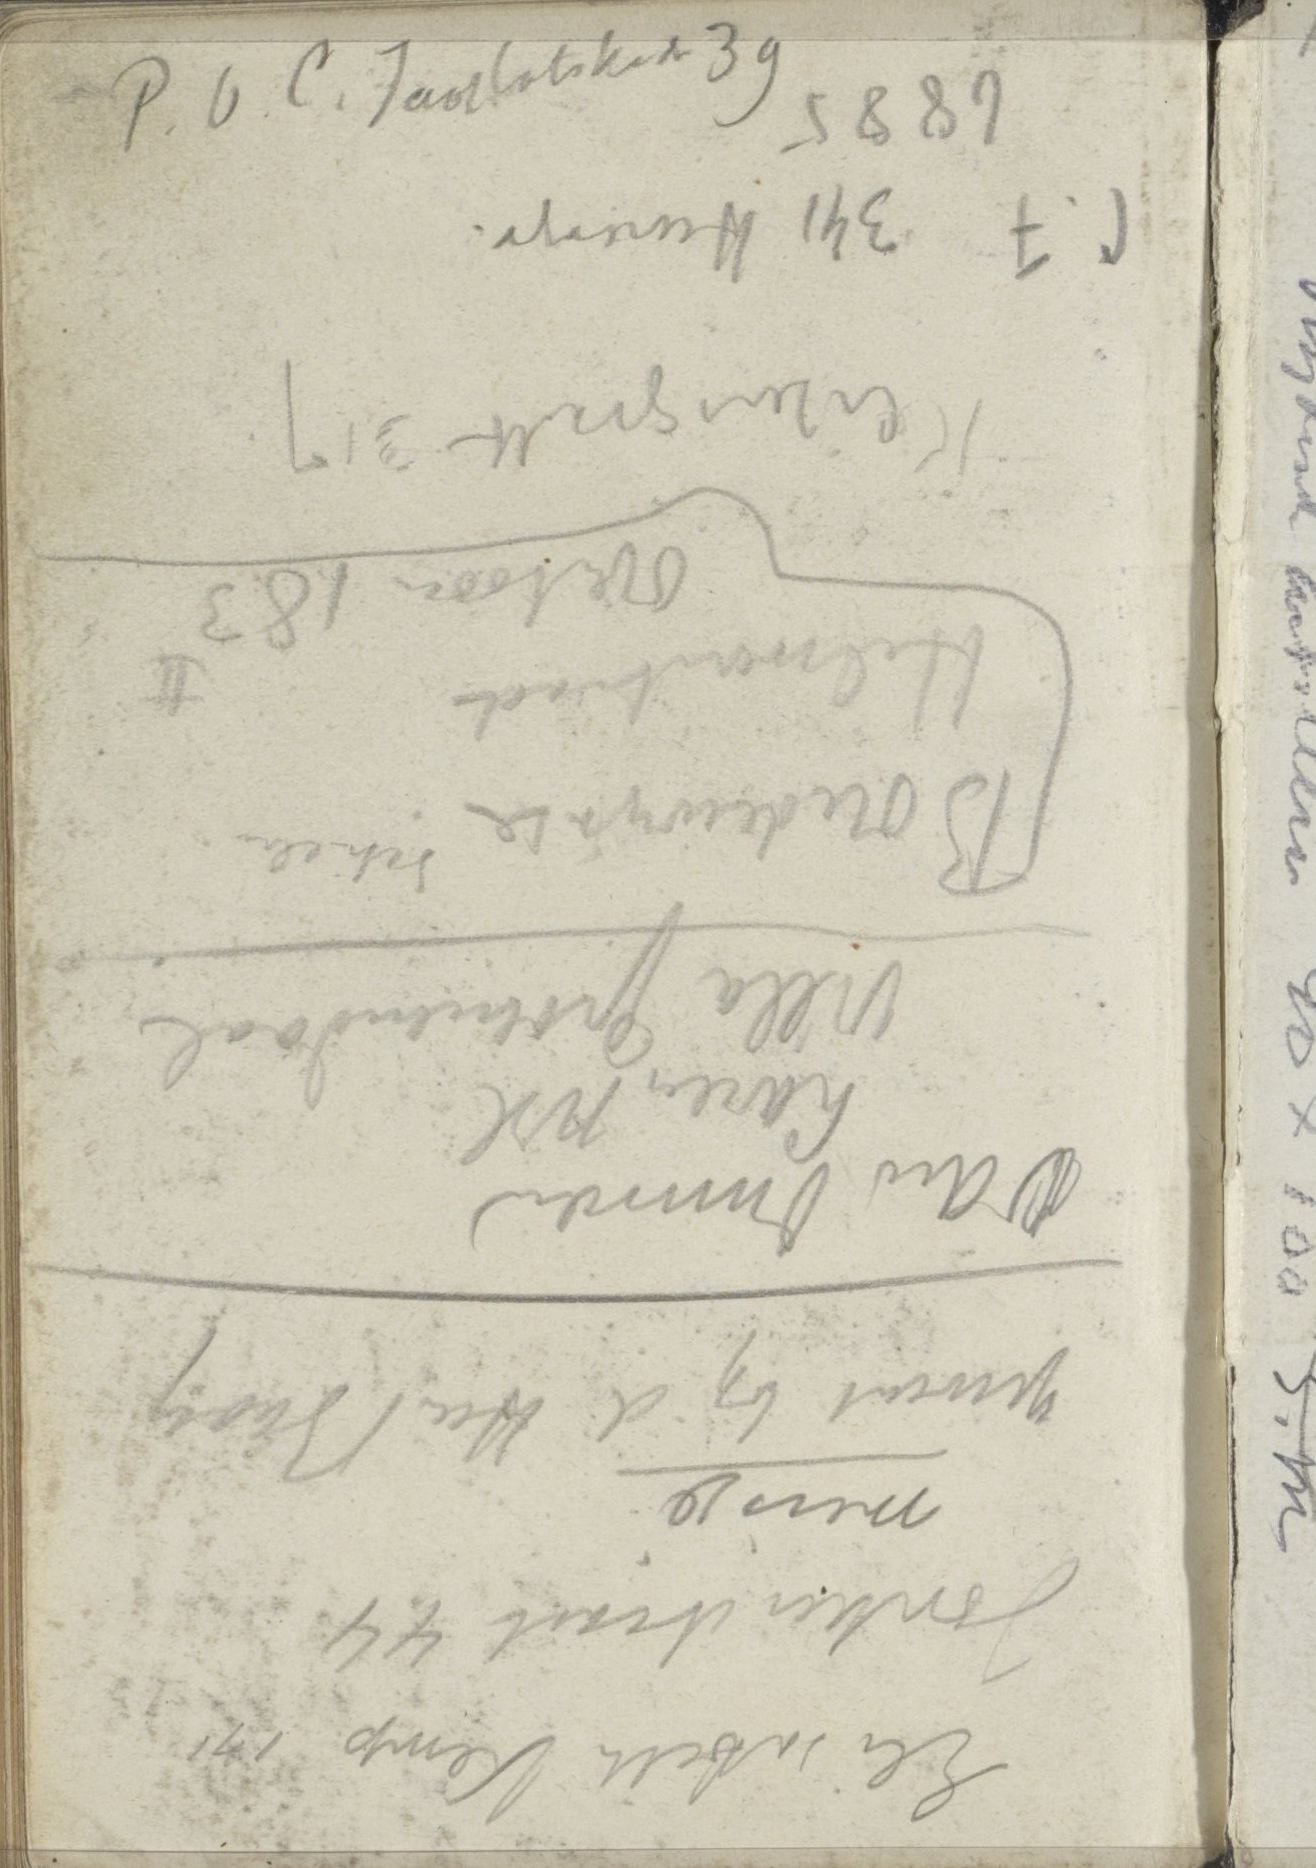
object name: sketchbook leaf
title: Annotaties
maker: george hendrik breitner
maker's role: draughtsman, painter, print maker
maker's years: 1857-1923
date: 1915-1916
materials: paper, pencil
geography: netherlands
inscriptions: annotation: ‘Elisabeth Kemp 171/ Jonkerstraat 44/ meisje/ geweest bij de Heer Baag[?]/ Van Ommen/ Laren NH/ Villa Groenendaal/ Boudewijnse Schiel[?]/ Helmerstraat/ Overtoom 183 II/ Keizersgracht 319/ C.F. 341 Heerengr. 6885/ P.O.C. Jacob Catskade 39’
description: Pagina 87 uit een schetsboek met 43 bladen.